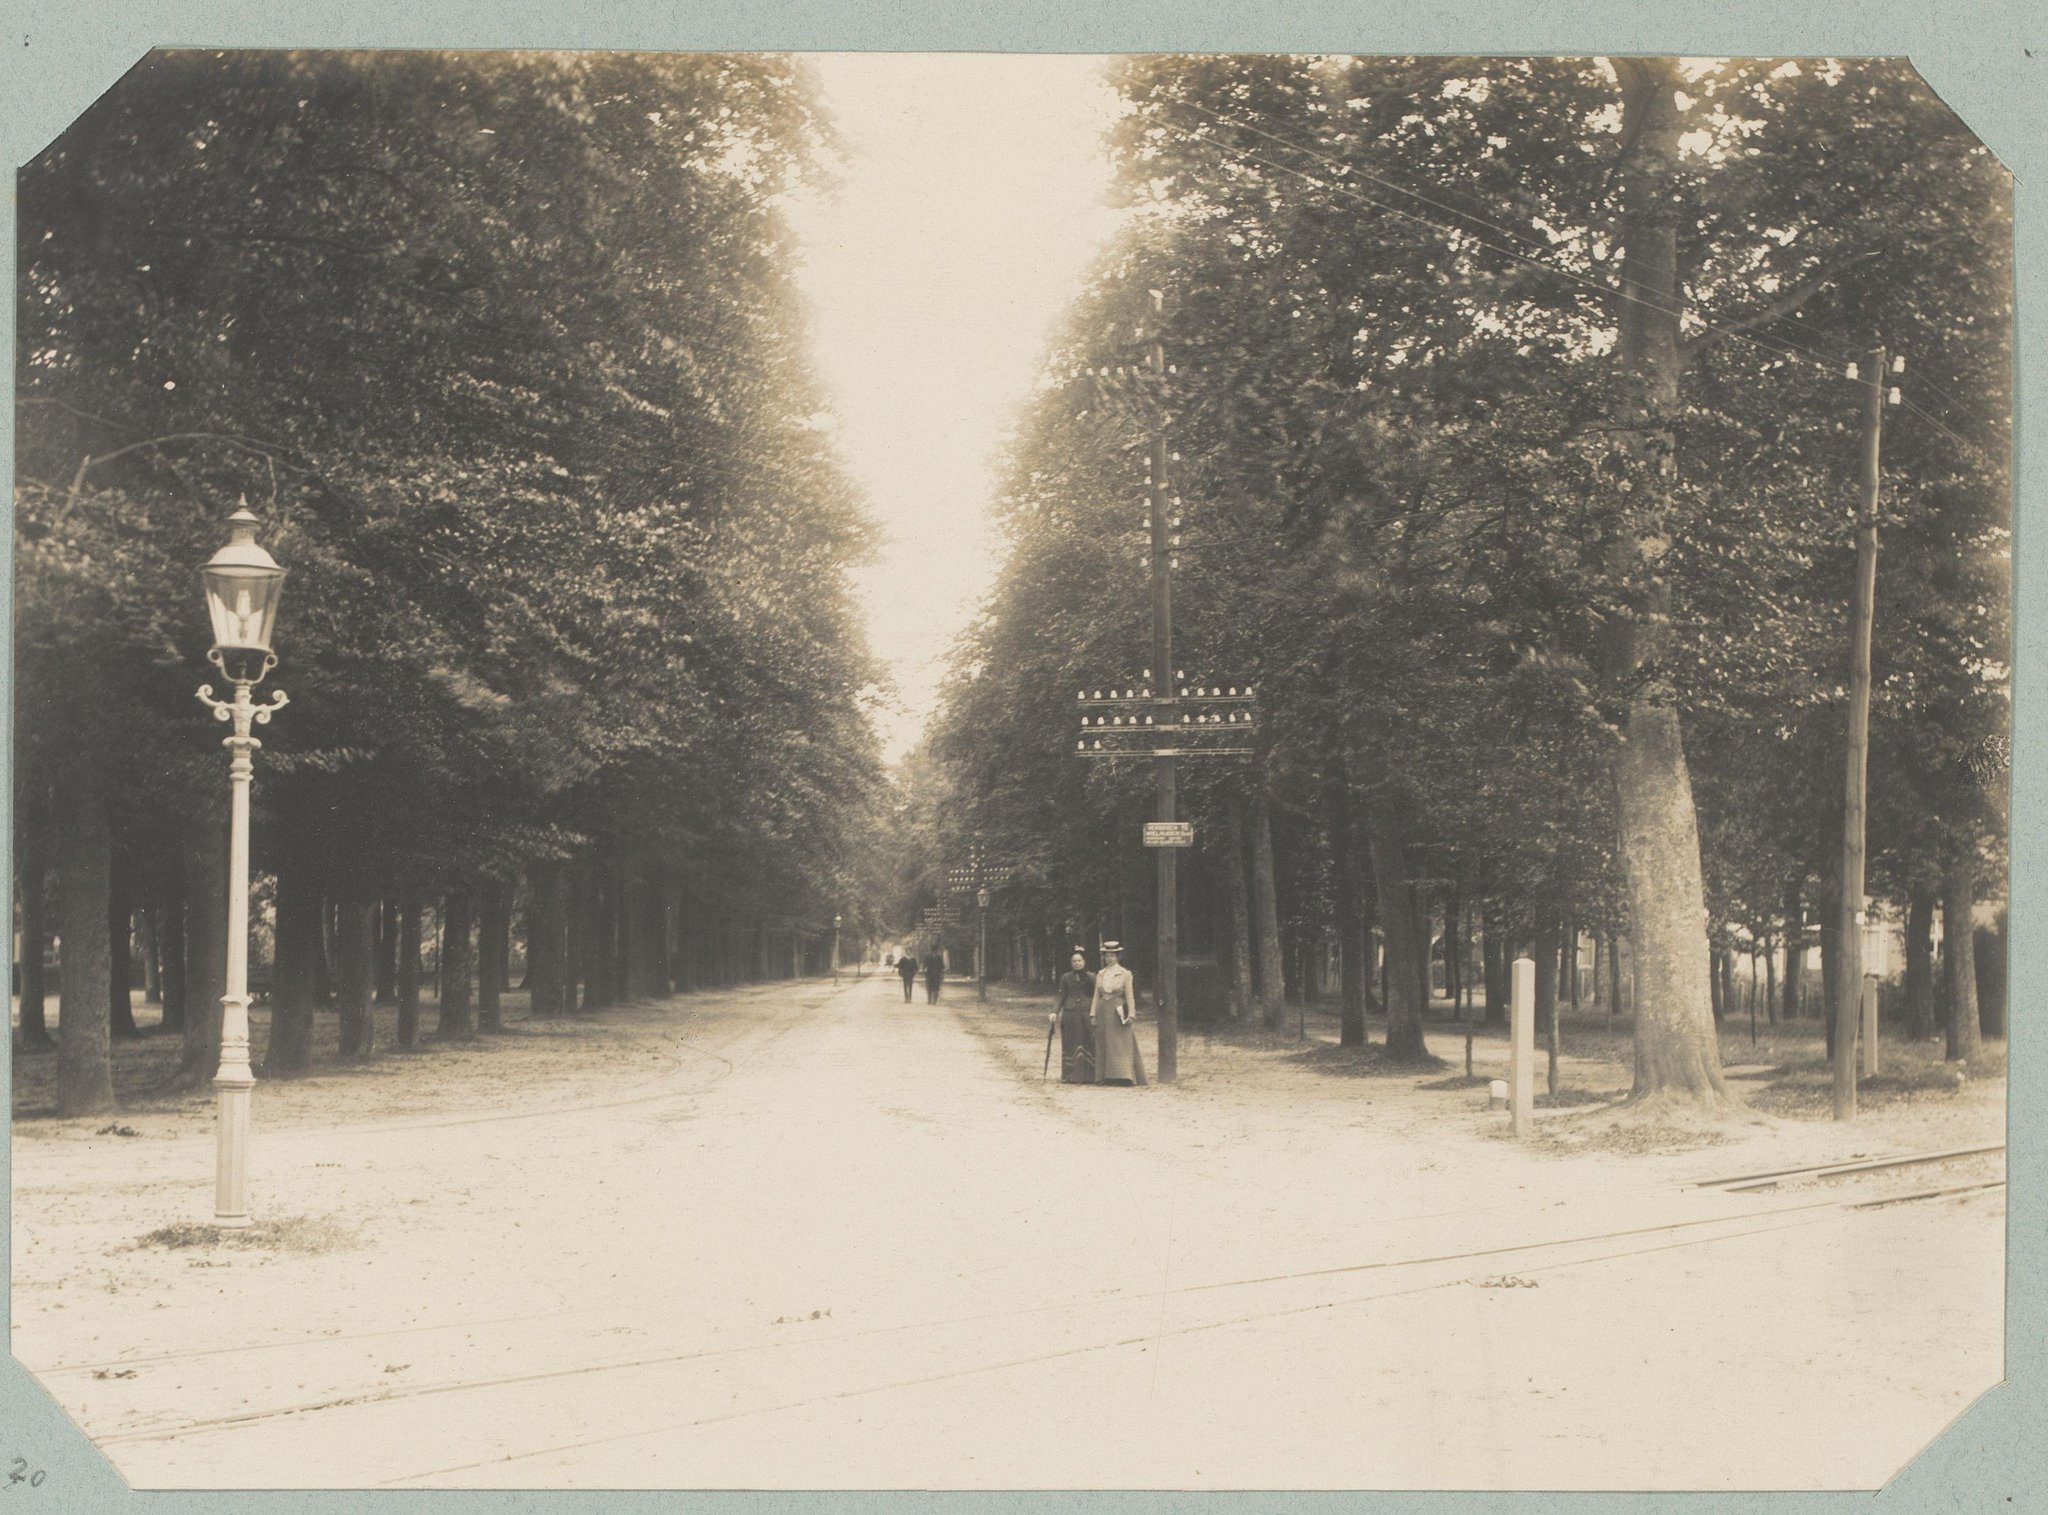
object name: photograph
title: Twee vrouwen op een laan met bomen in Nederland, mogelijk de Maliebaan in Utrecht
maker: Anonymous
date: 1890-1900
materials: paper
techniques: gelatin silver print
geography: netherlands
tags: forest path or lane, netherlands